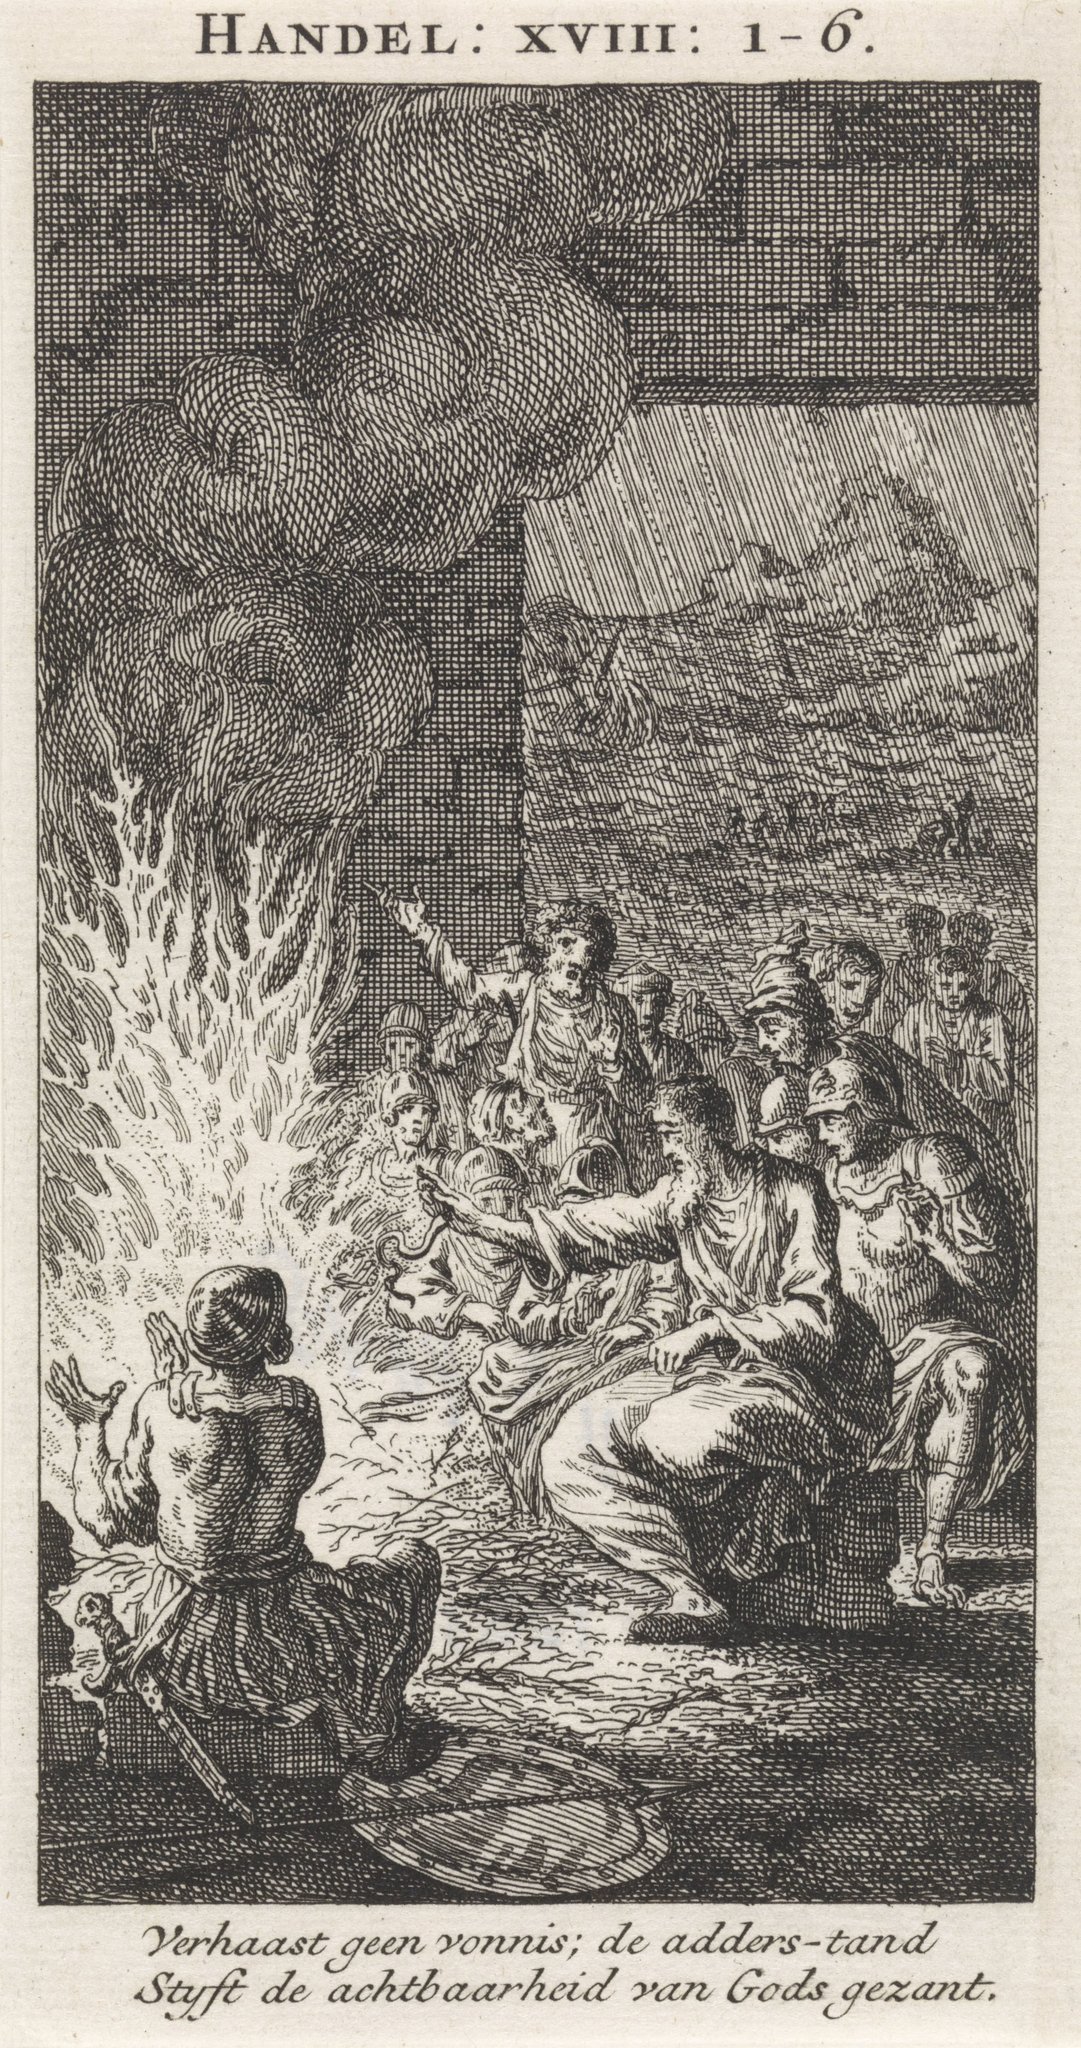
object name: print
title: Paulus wordt gebeten door een adder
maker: Anonymous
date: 1712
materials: paper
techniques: etching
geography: amsterdam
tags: paul bitten by a viper (when throwing wood on the fire)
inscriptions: collector's mark: Lugt 2228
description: Kopie van illustratie voor: Luyken, Jan. Bybel printen. Amsterdam: Pieter Arentsz. II (wed.) en Cornelis van der Sys, 1712, p. 41.